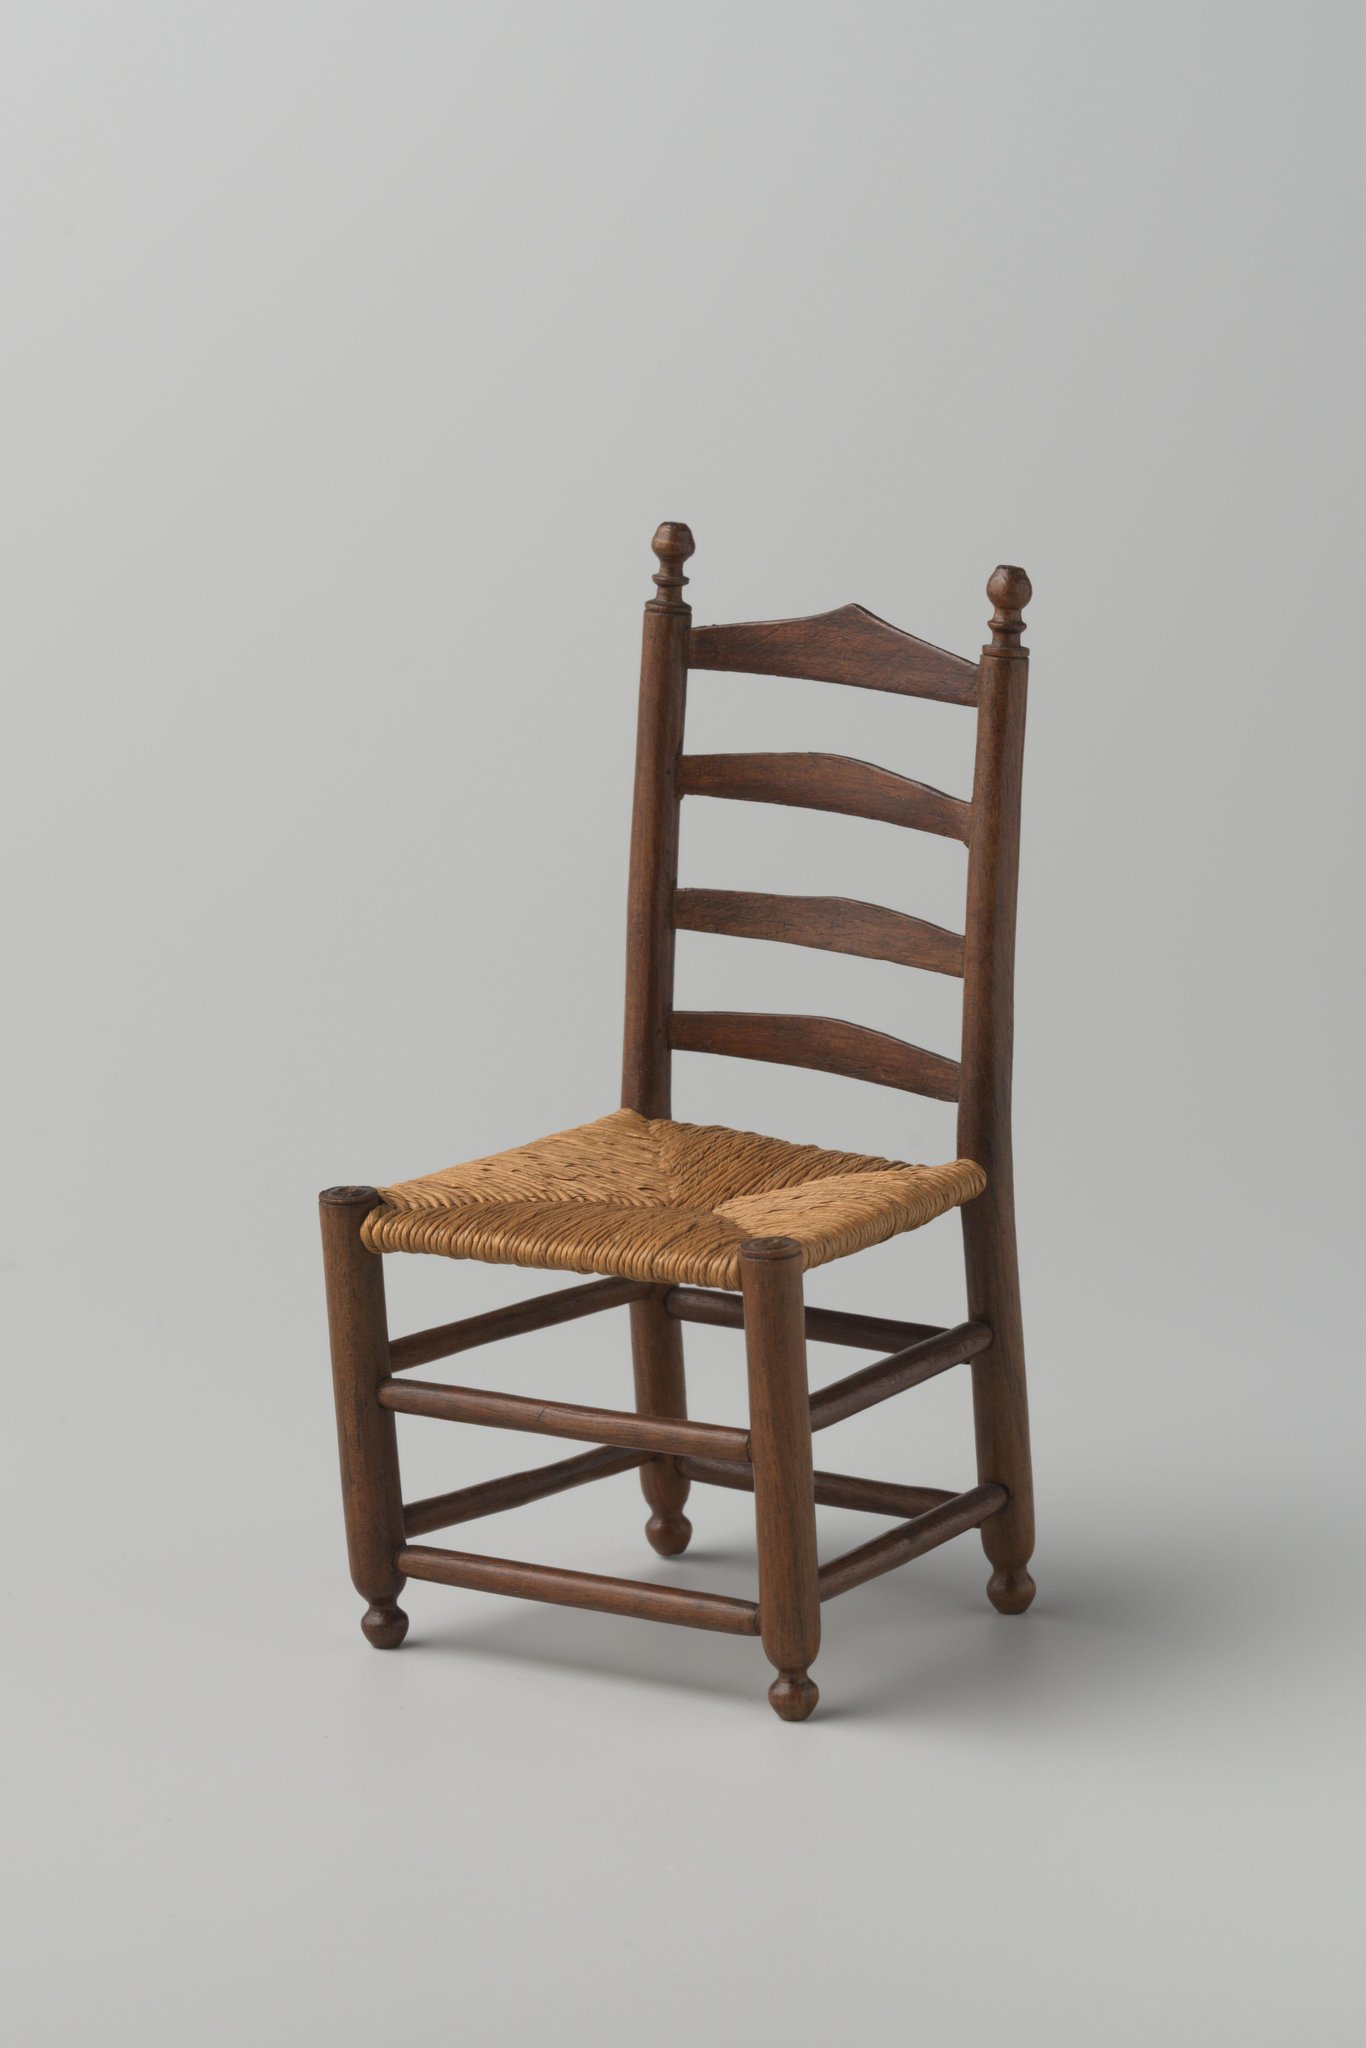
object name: chair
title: Knopstoel met matten zitting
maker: Anonymous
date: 1690-1710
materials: fiber, wood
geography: amsterdam